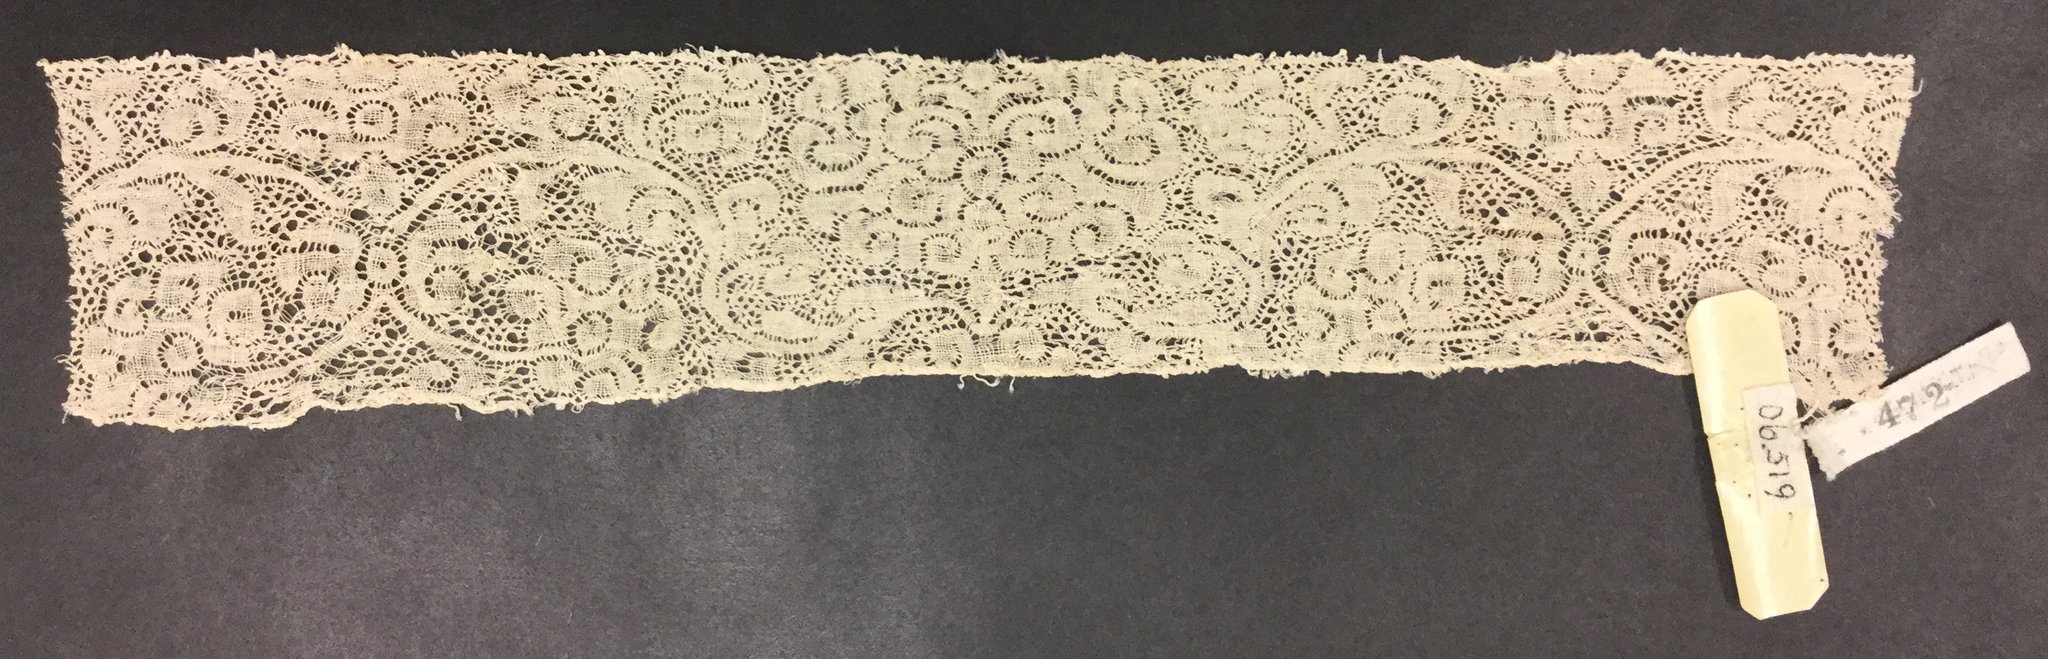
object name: fragment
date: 1601-1700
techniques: lace